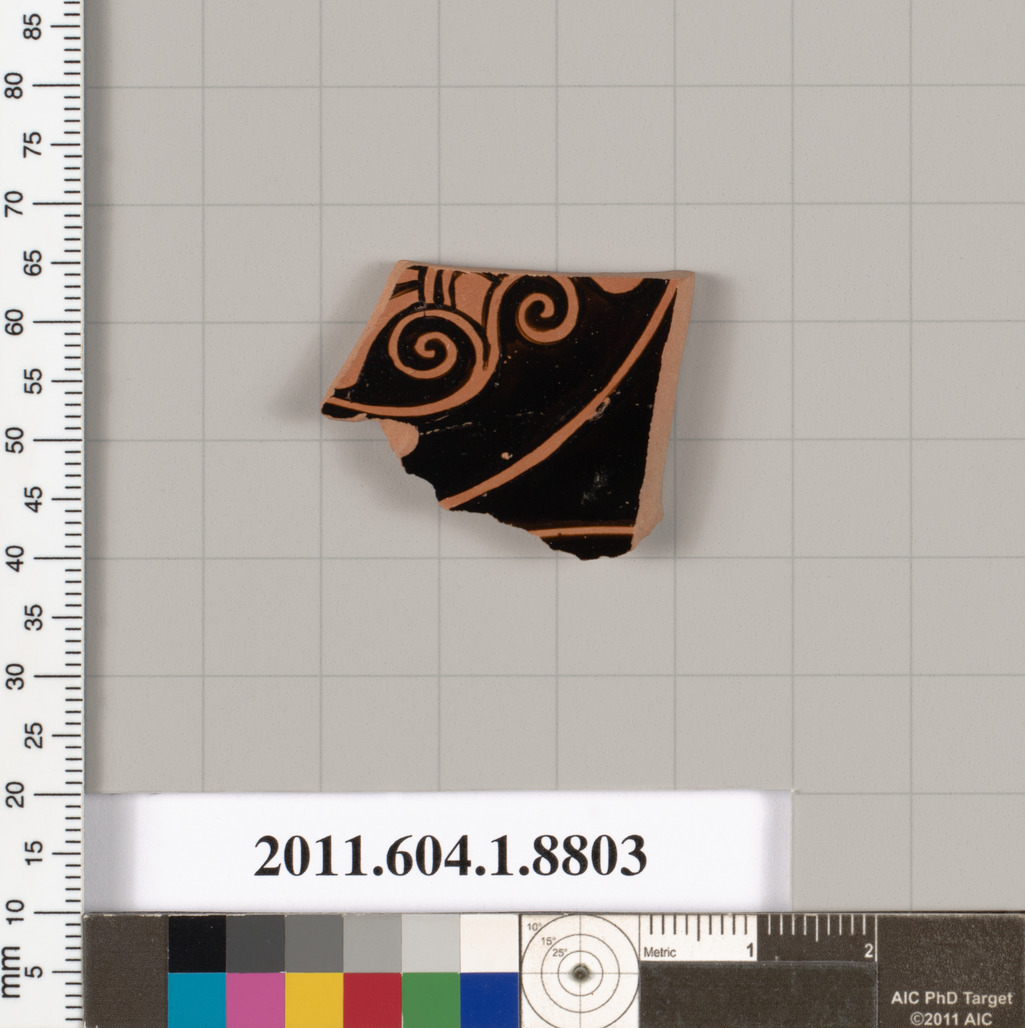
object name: kylix fragment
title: Terracotta fragment of a kylix (drinking cup)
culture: greek, attic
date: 490-480 BCE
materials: terracotta